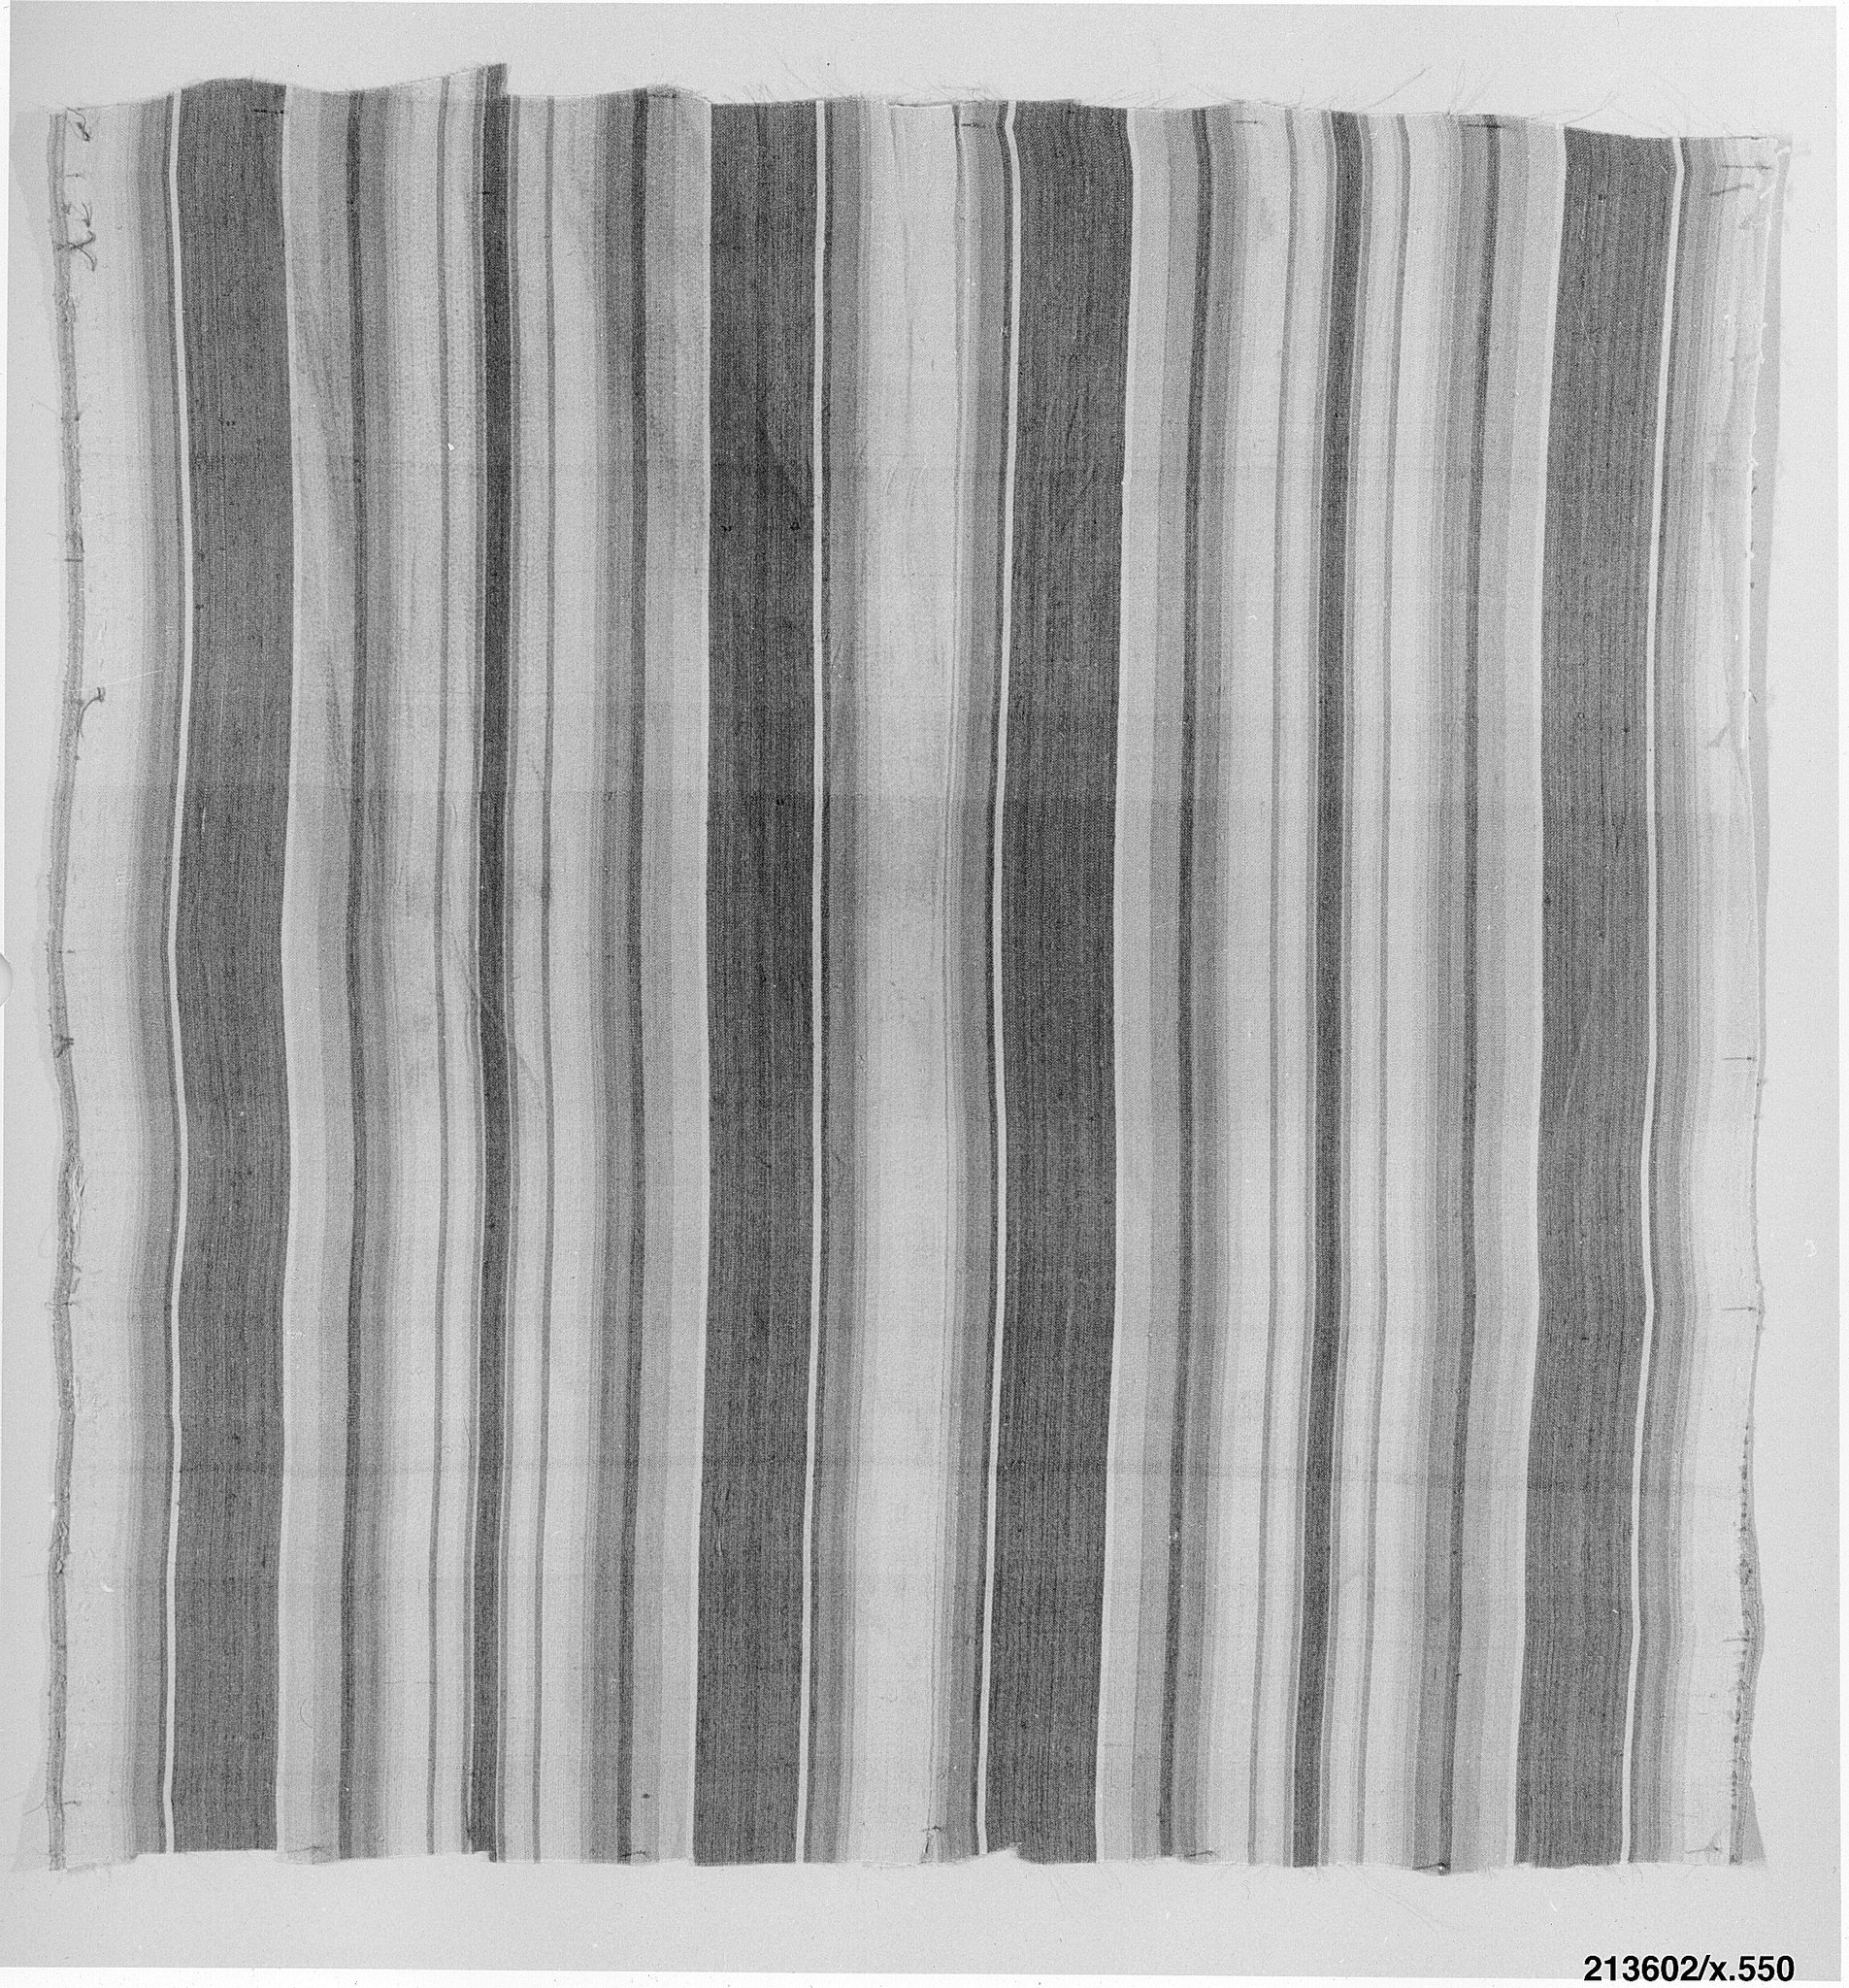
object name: piece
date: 1701-1800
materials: silk